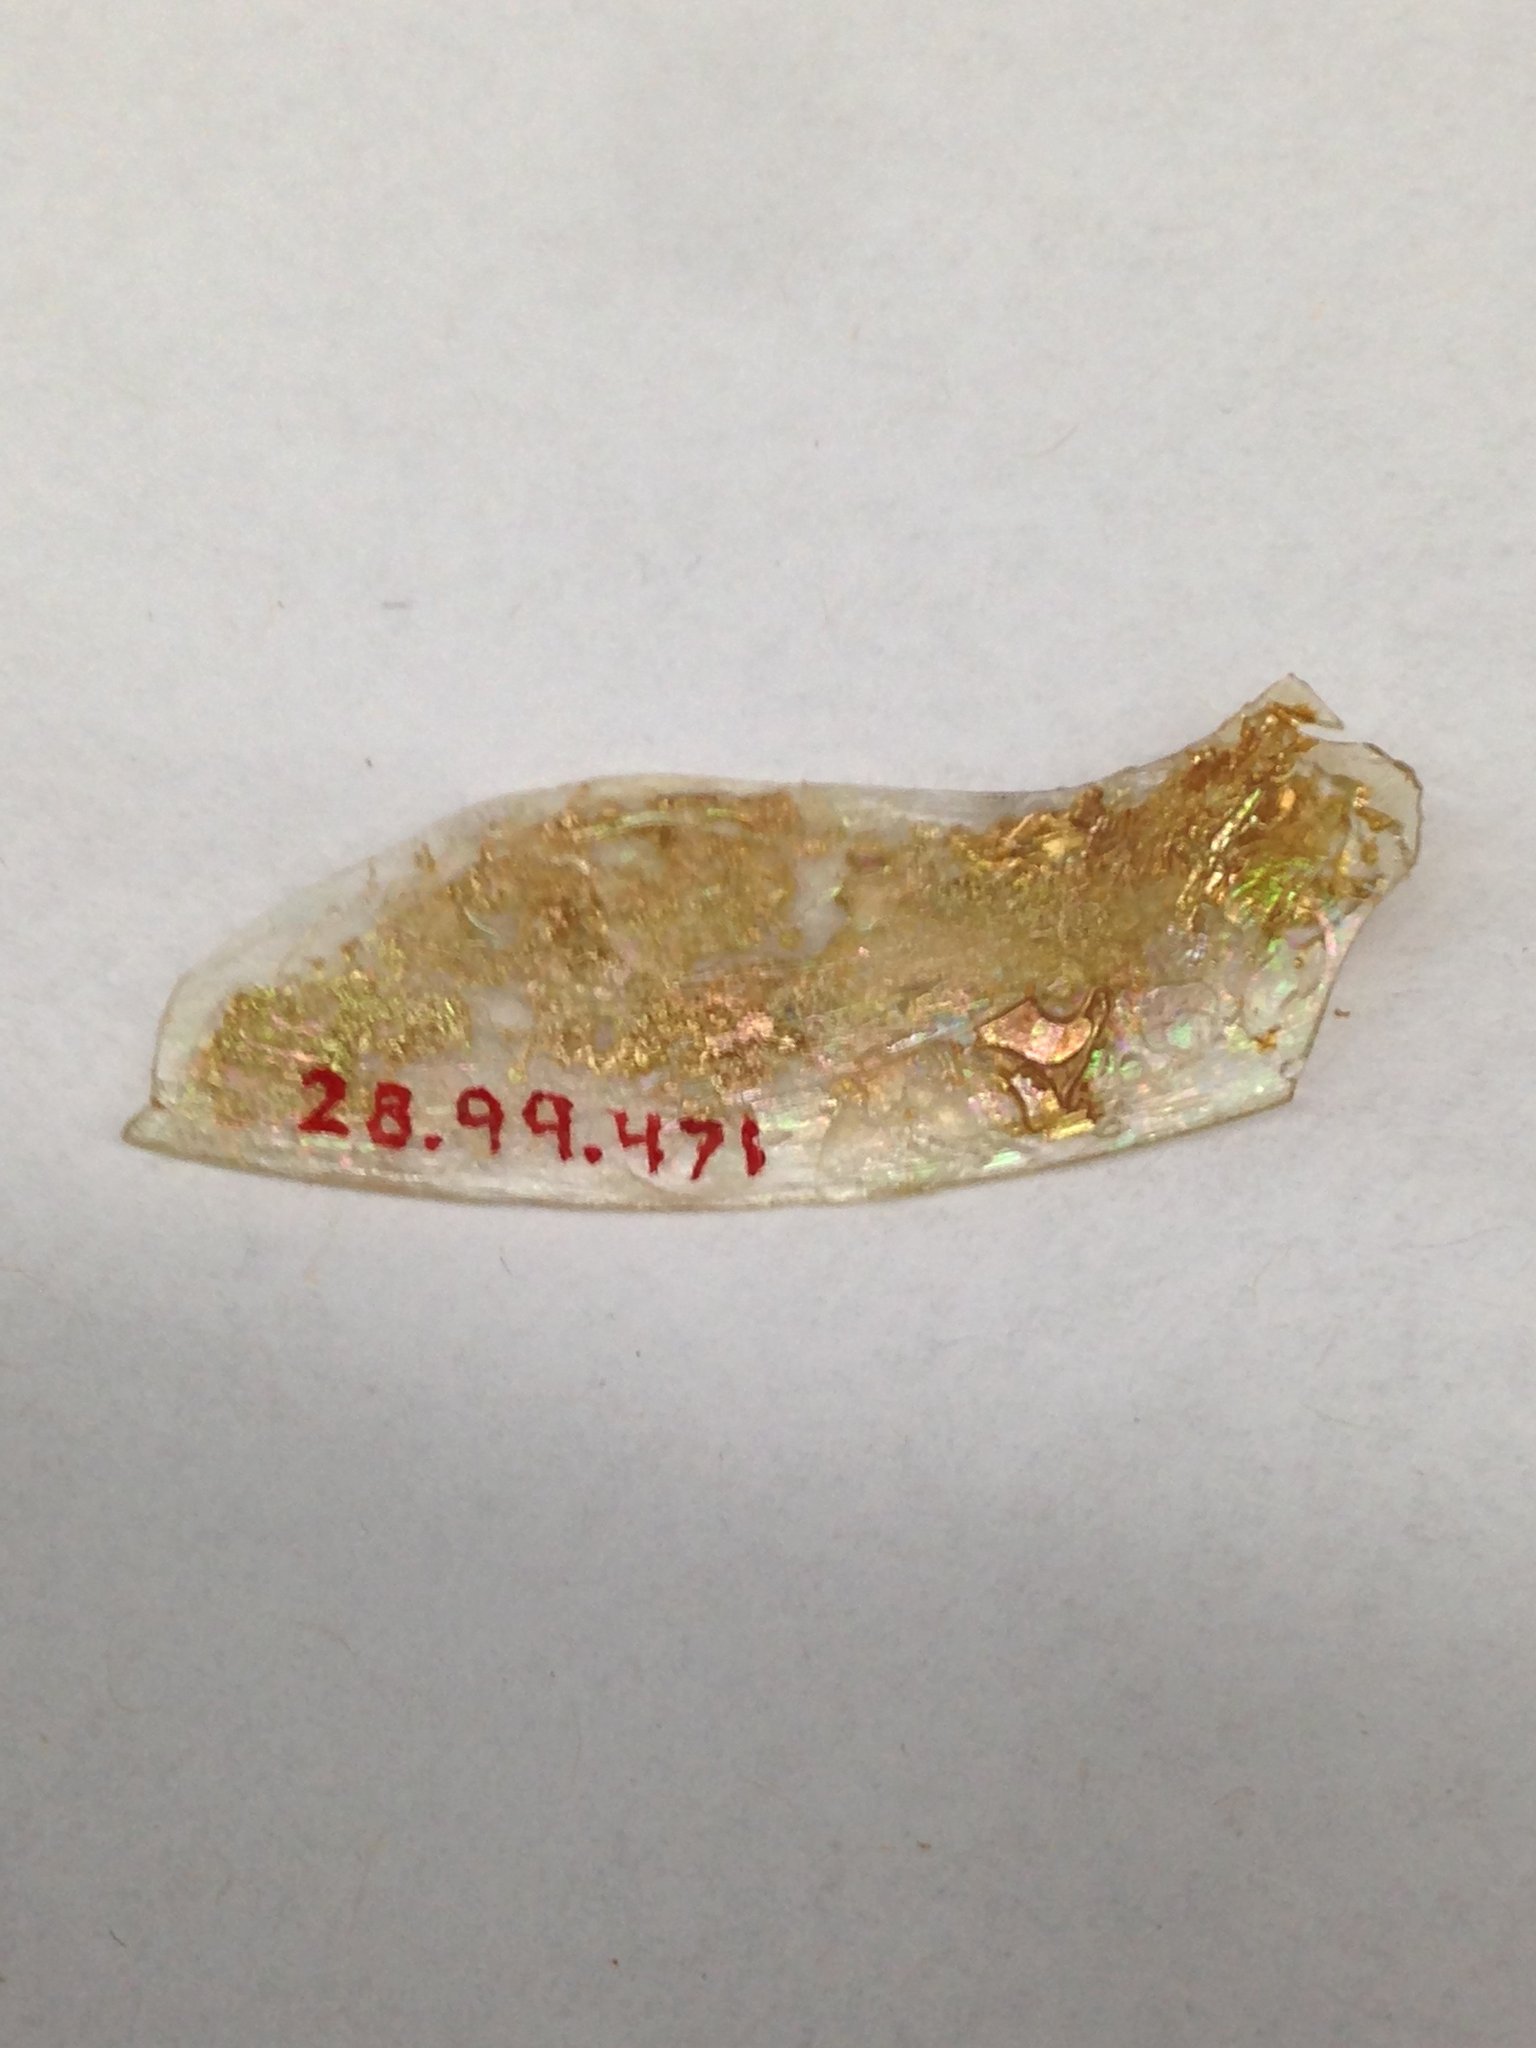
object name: fragment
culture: european or middle eastern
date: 1150-1250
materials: ceramic, glass